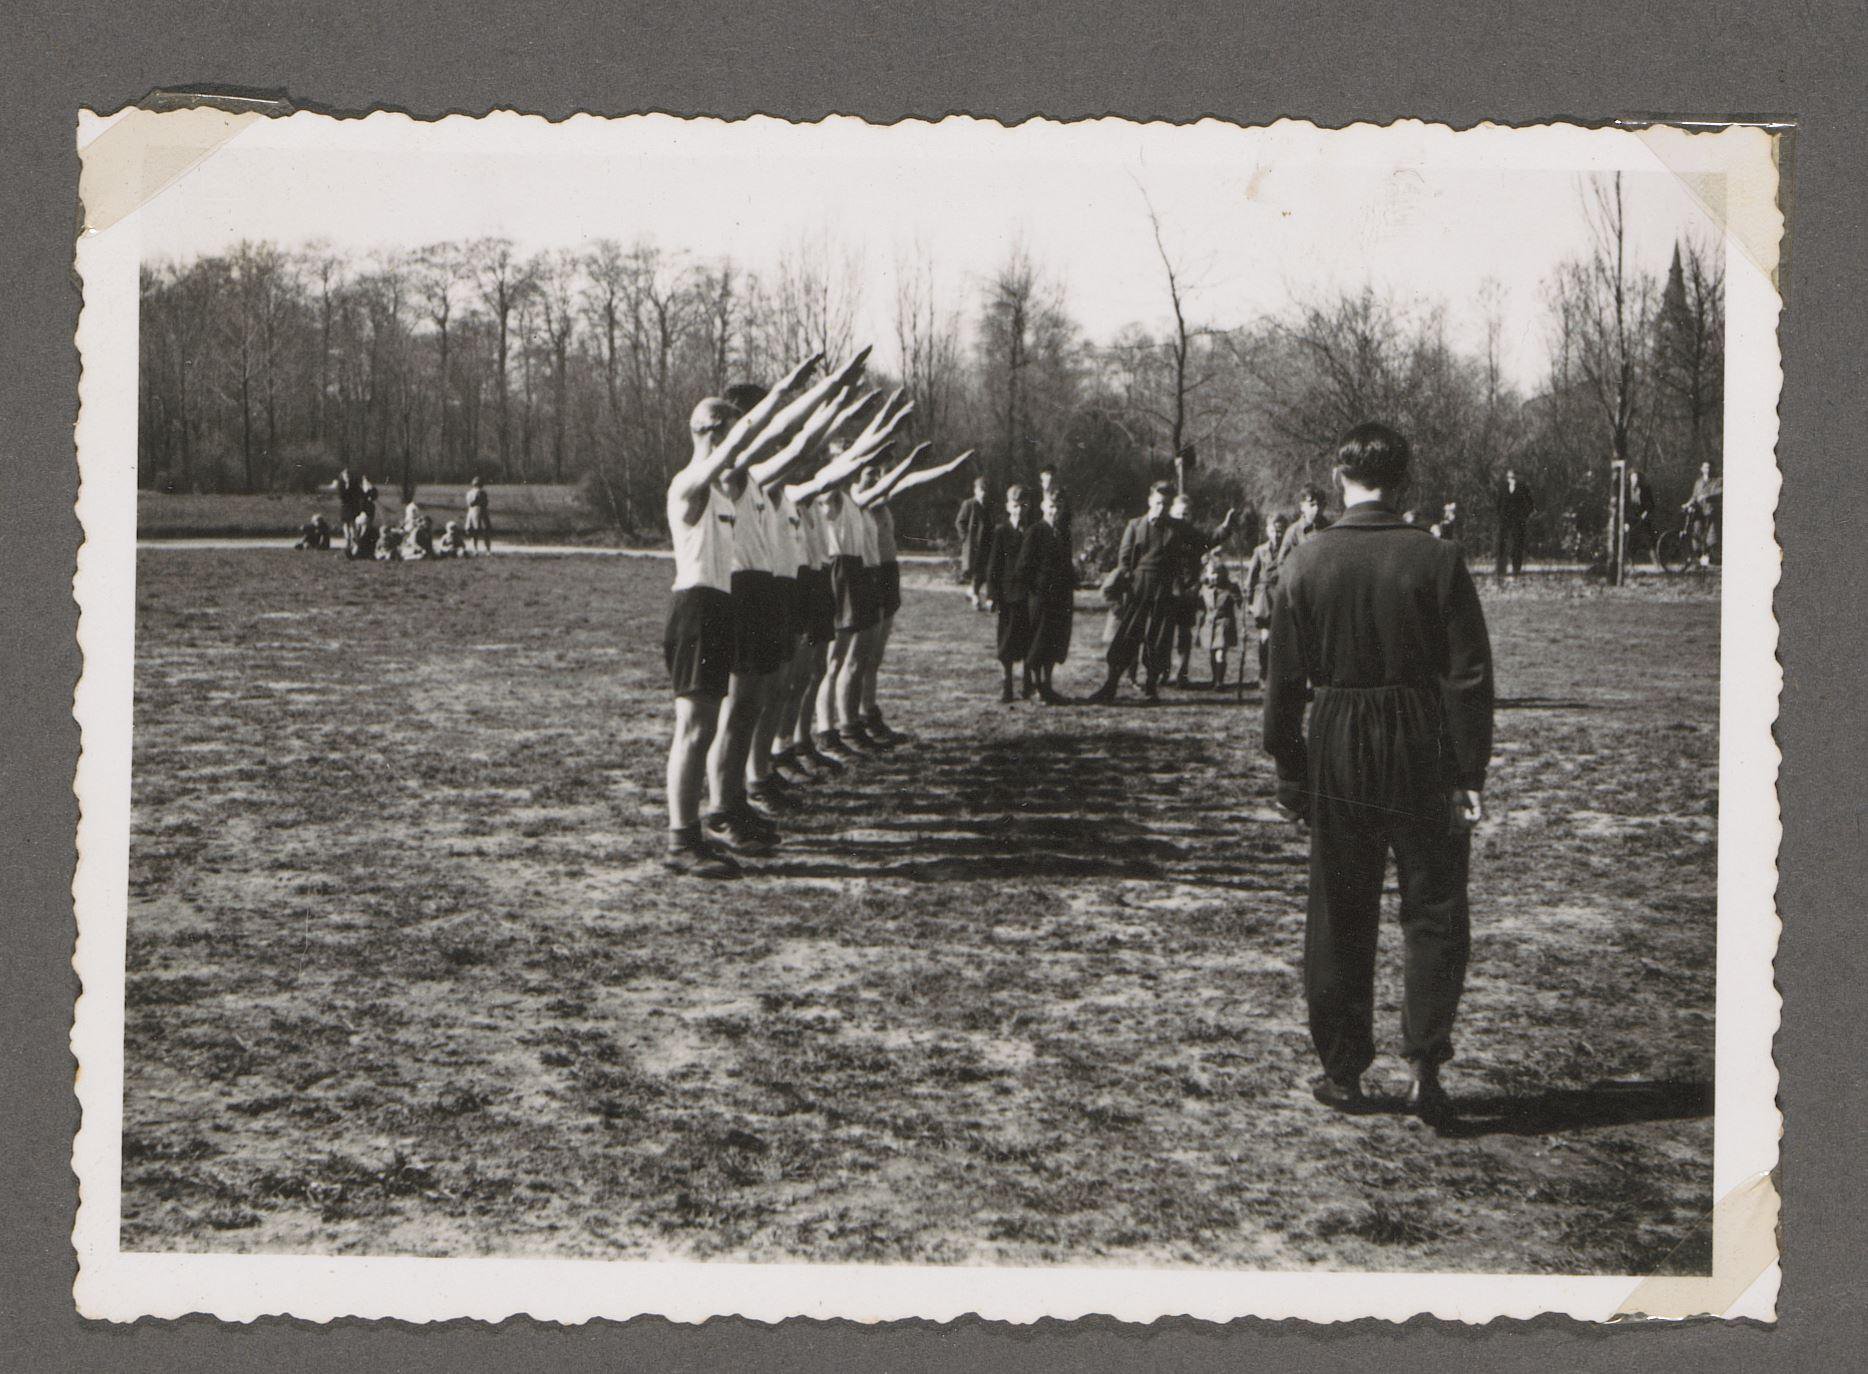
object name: album leaf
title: Voetbalwedstrijd tussen de manschappen en de officieren; spelers brengen voor of na de wedstrijd de Hitlergroet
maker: Anonymous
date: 1941-1945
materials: paper, photographic support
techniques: gelatin silver print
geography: netherlands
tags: the company, the unit, the troop ~ military service, soccer, football (early names: soule, choule, cholle), netherlands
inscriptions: inscription: ‘Fußballspiel des U. Stabes / Mannschaften gegen Uffz. und Offz. / 3: 0 Für die Mannschaften’